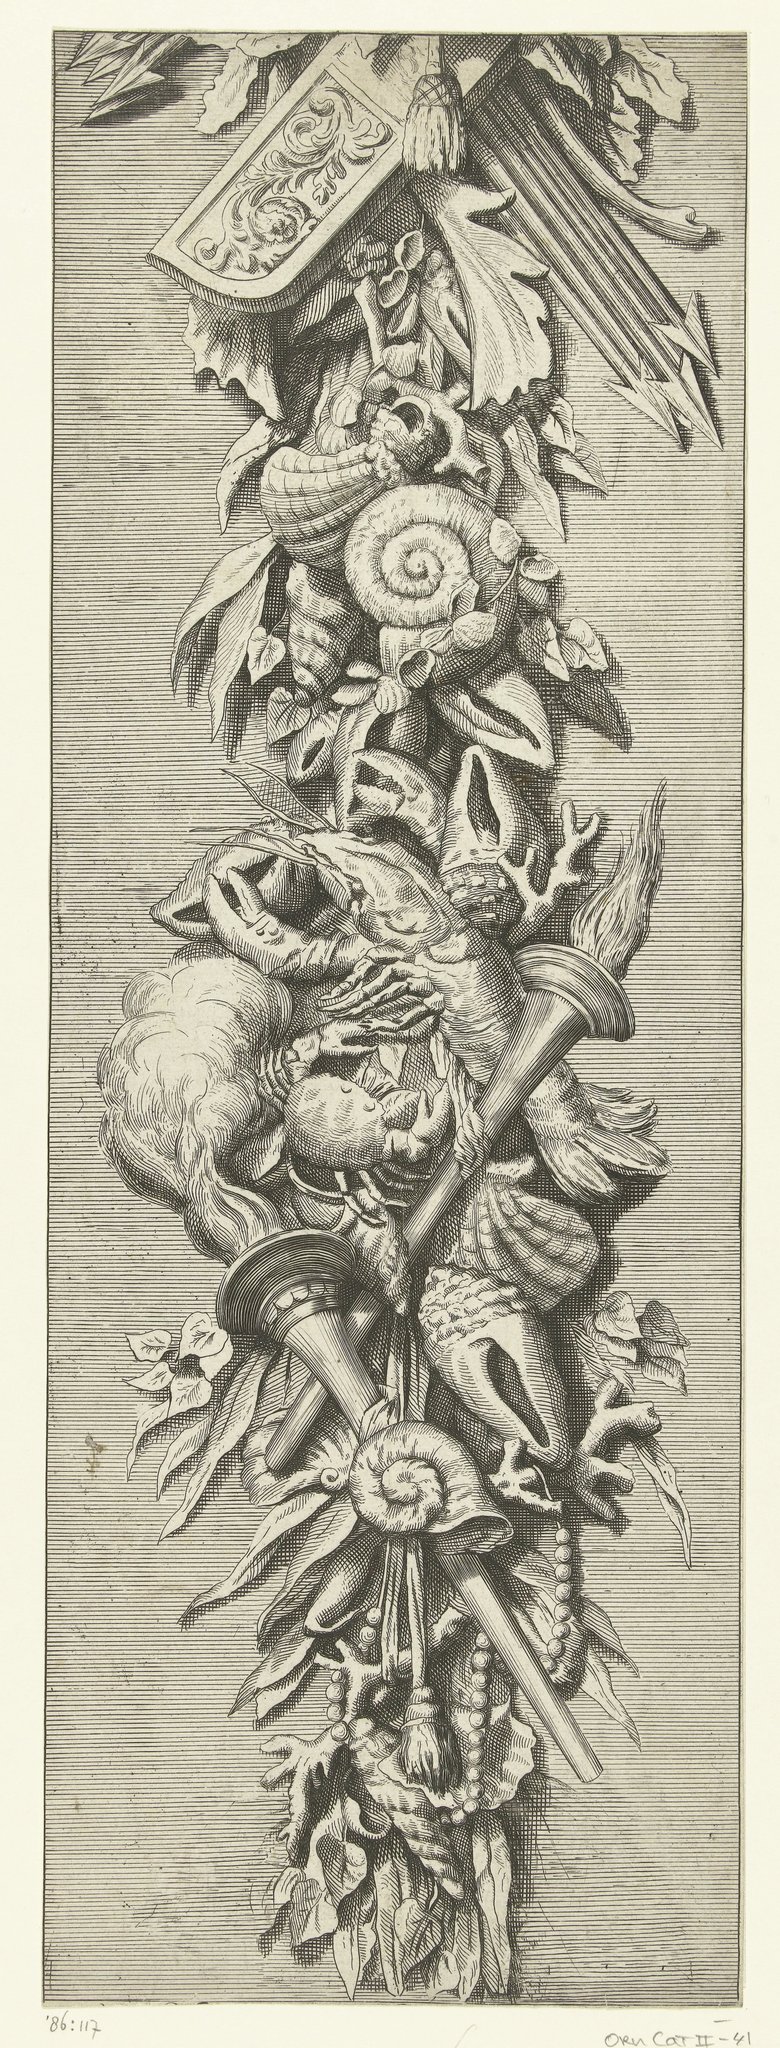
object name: ornament print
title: Trofeeën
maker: Anonymous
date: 1675-1700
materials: paper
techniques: etching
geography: netherlands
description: Onder de pijlkoker hangen schelpen, koraal, een krab, een kreeft, twee fakkels en bladeren. Met parallel-arcering op de achtergrond.